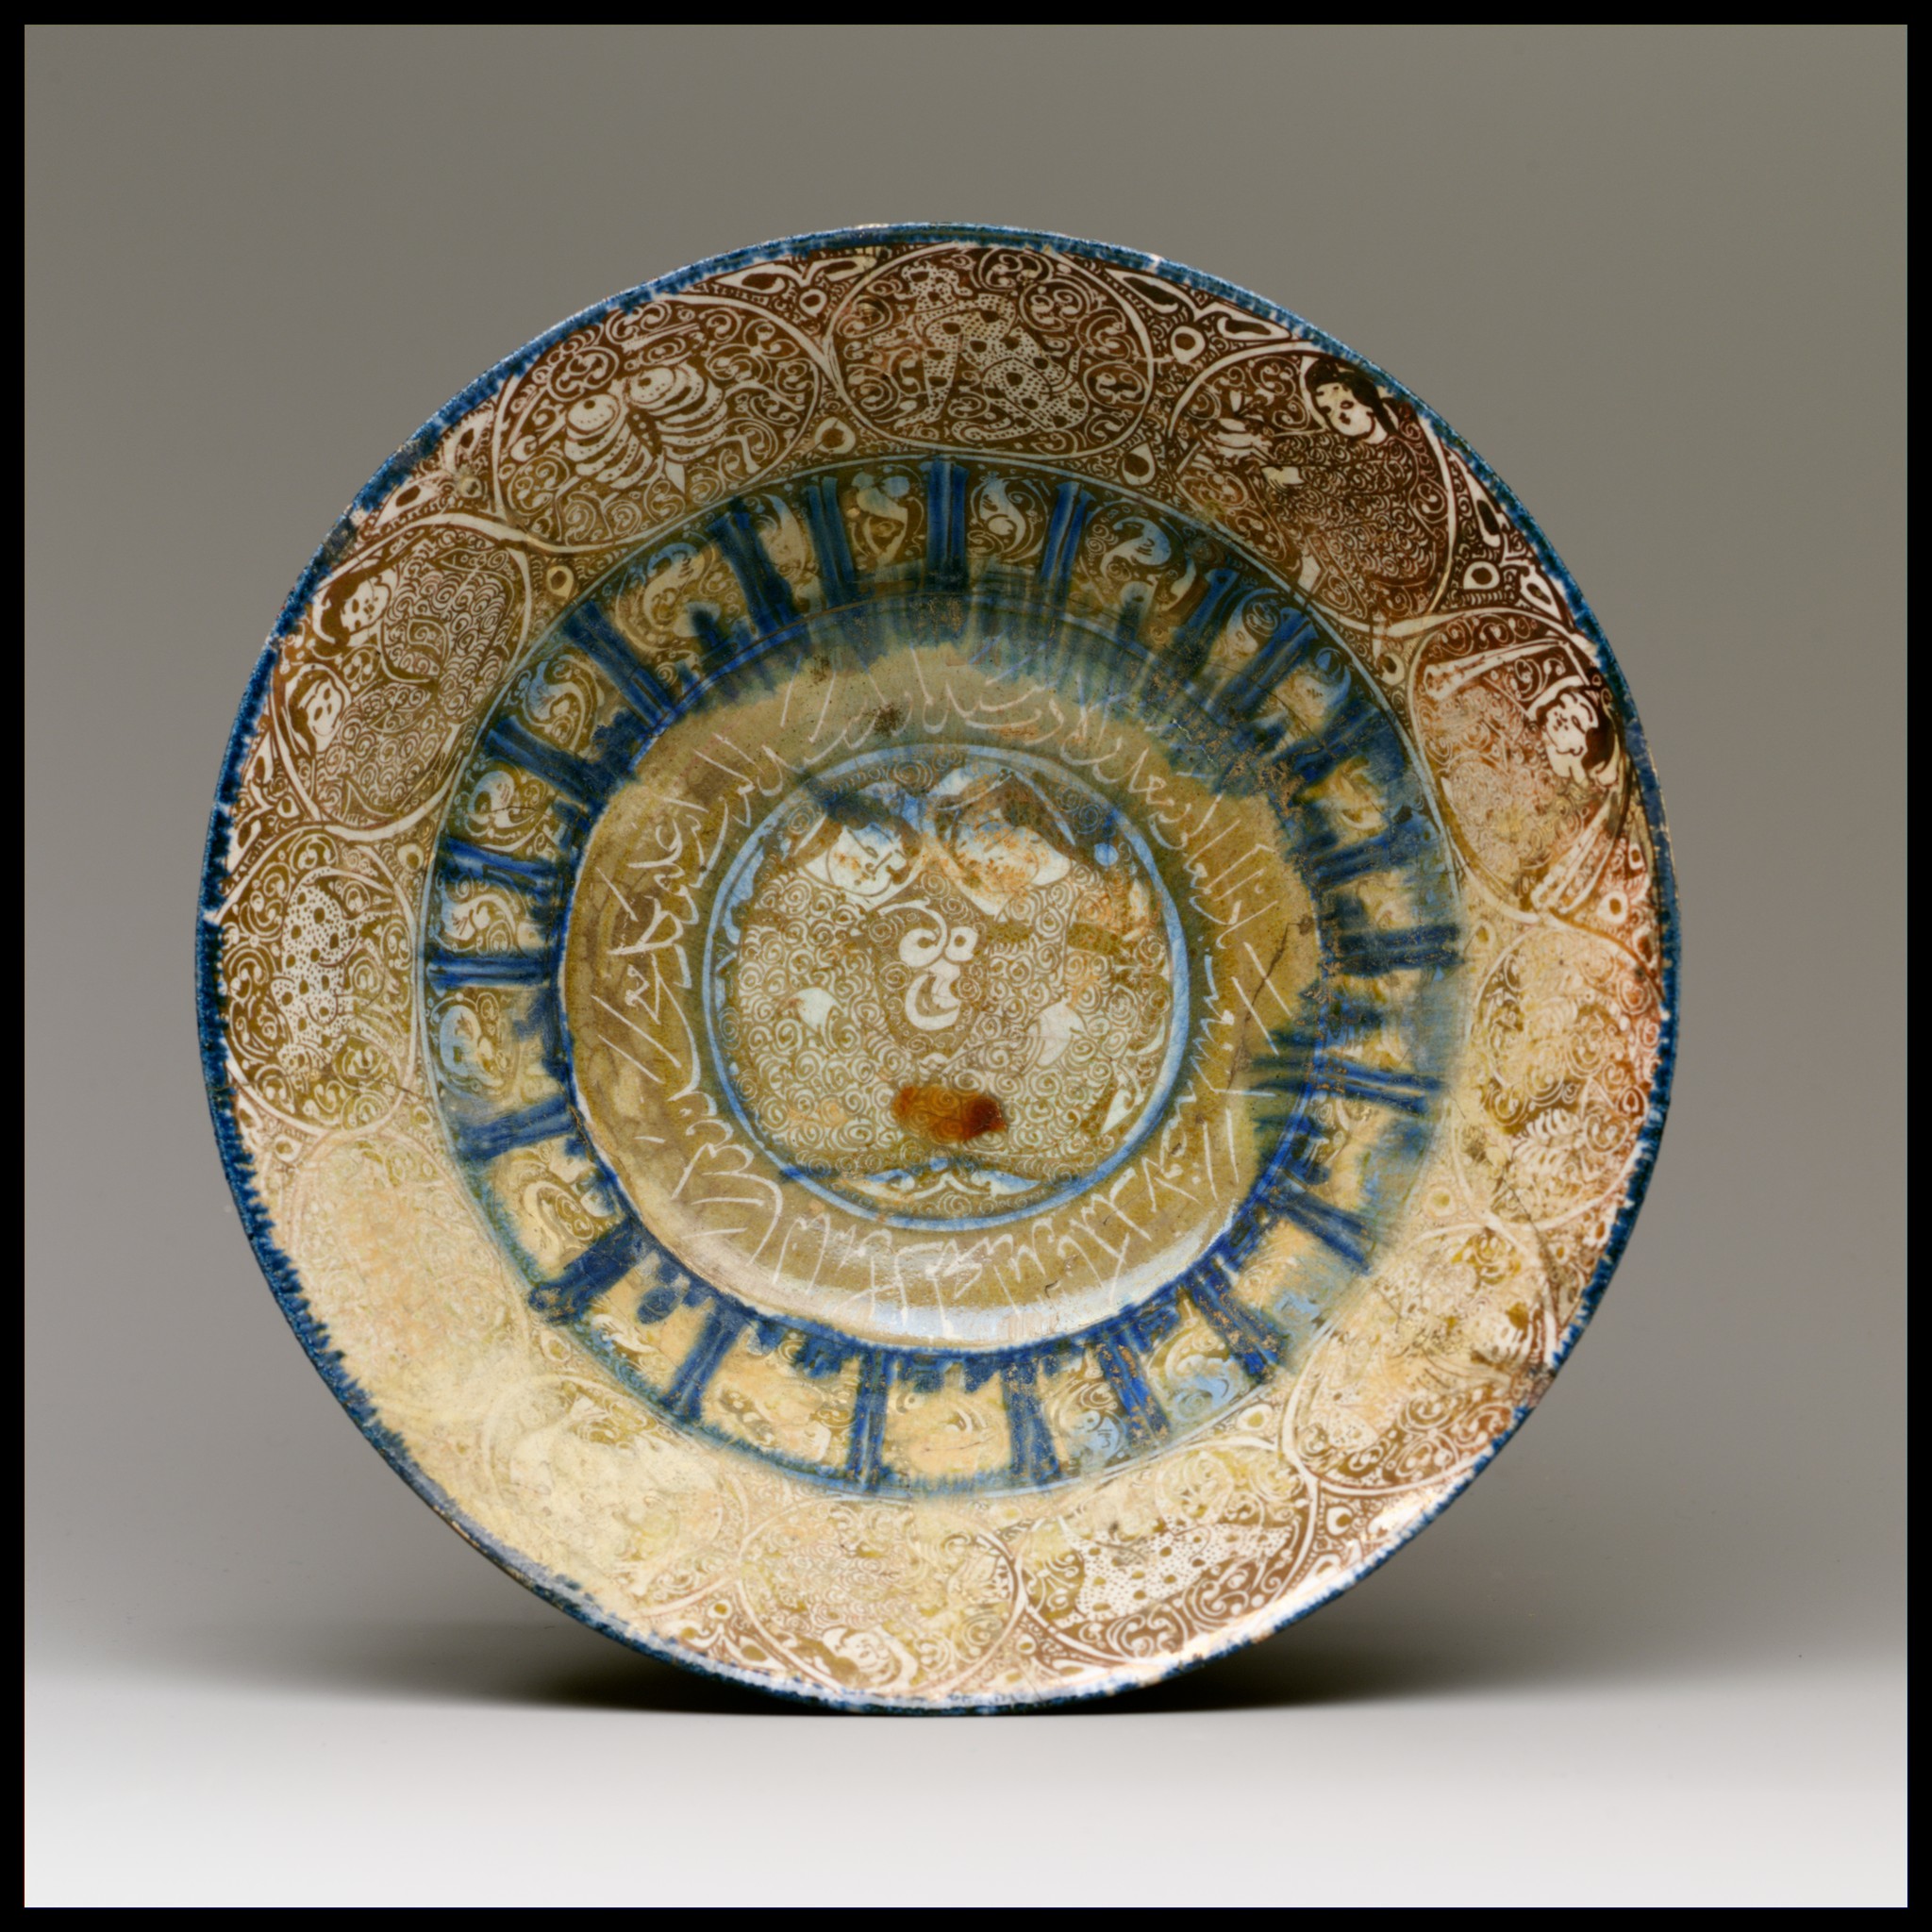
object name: bowl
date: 1201-1300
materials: glaze, stonepaste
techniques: luster painting, overglaze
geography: iran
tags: zodiac